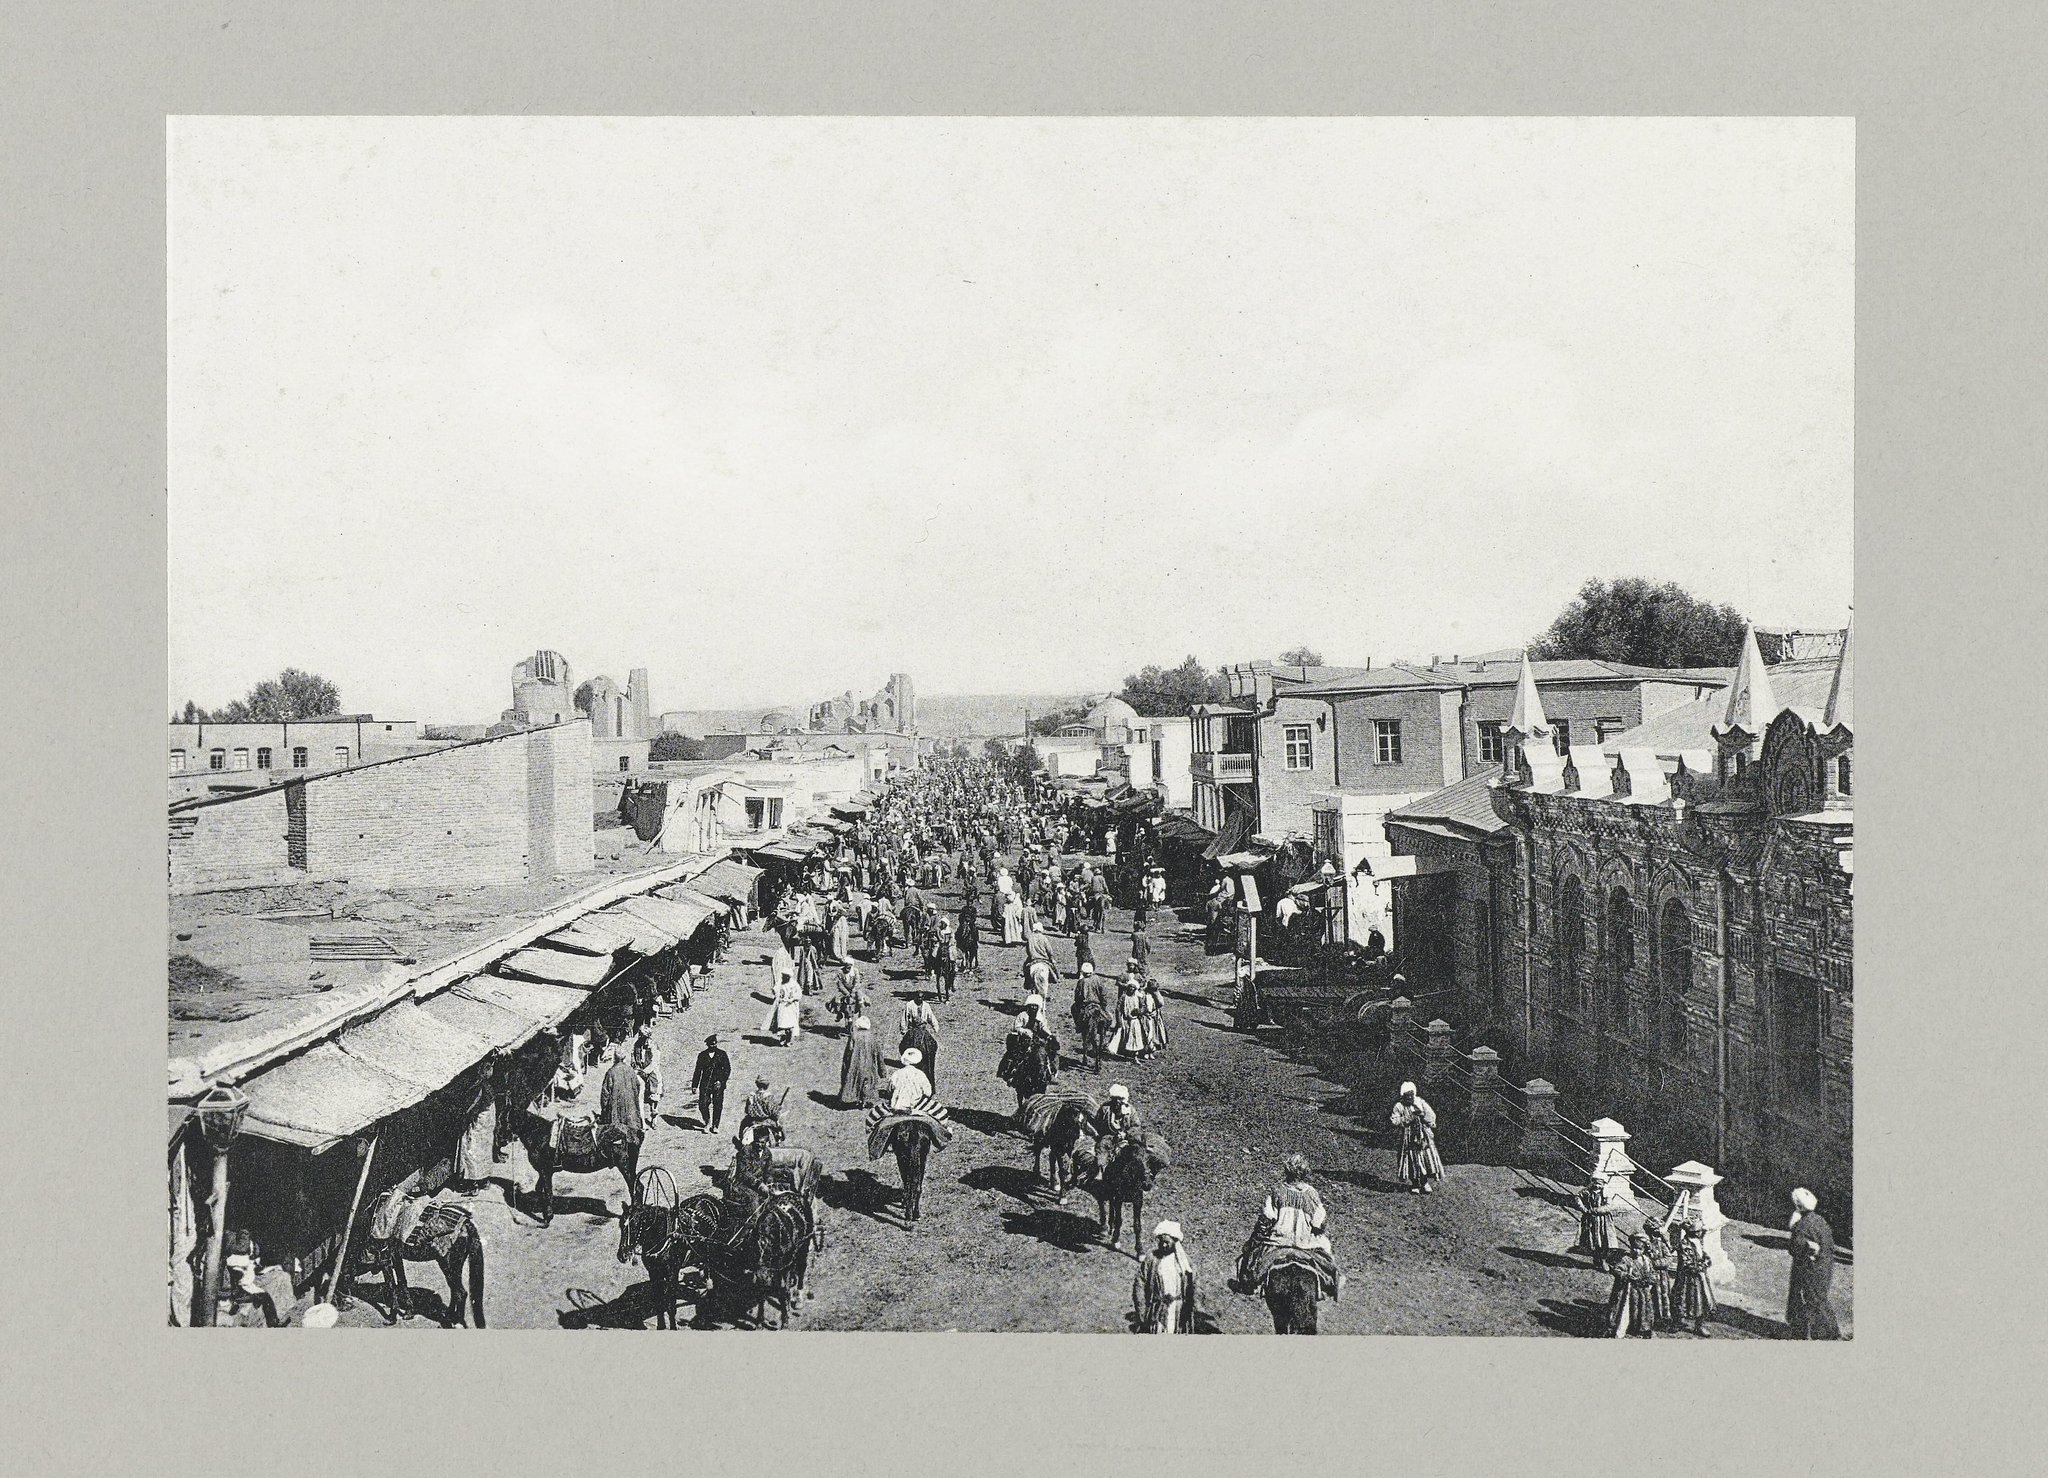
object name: photomechanical print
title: Hoofdstraat van de Inlandse (?) wijk te Samarkand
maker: Anonymous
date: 1895-1915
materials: cardboard, paper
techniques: photograph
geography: samarqand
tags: samarqand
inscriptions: annotation: ‘5. Hoofdstraat der Inl. wijk te Samarkand.’